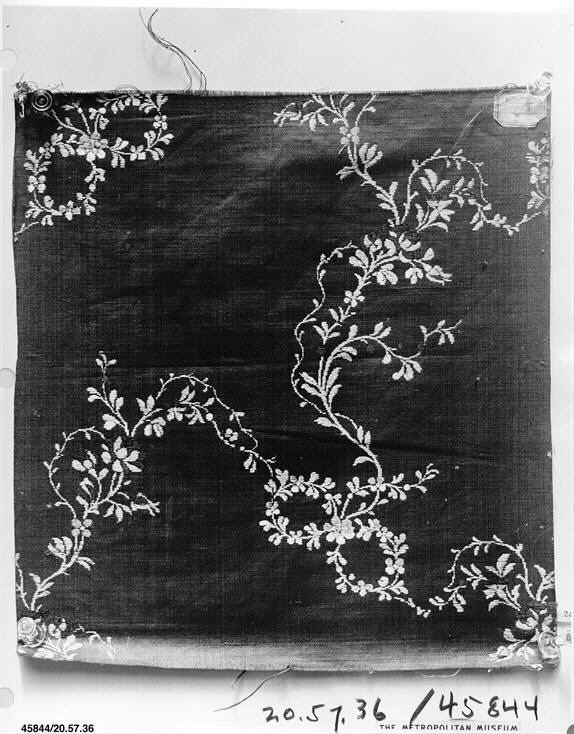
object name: fragment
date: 1760-1770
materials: cotton, silk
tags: flowers,leaves